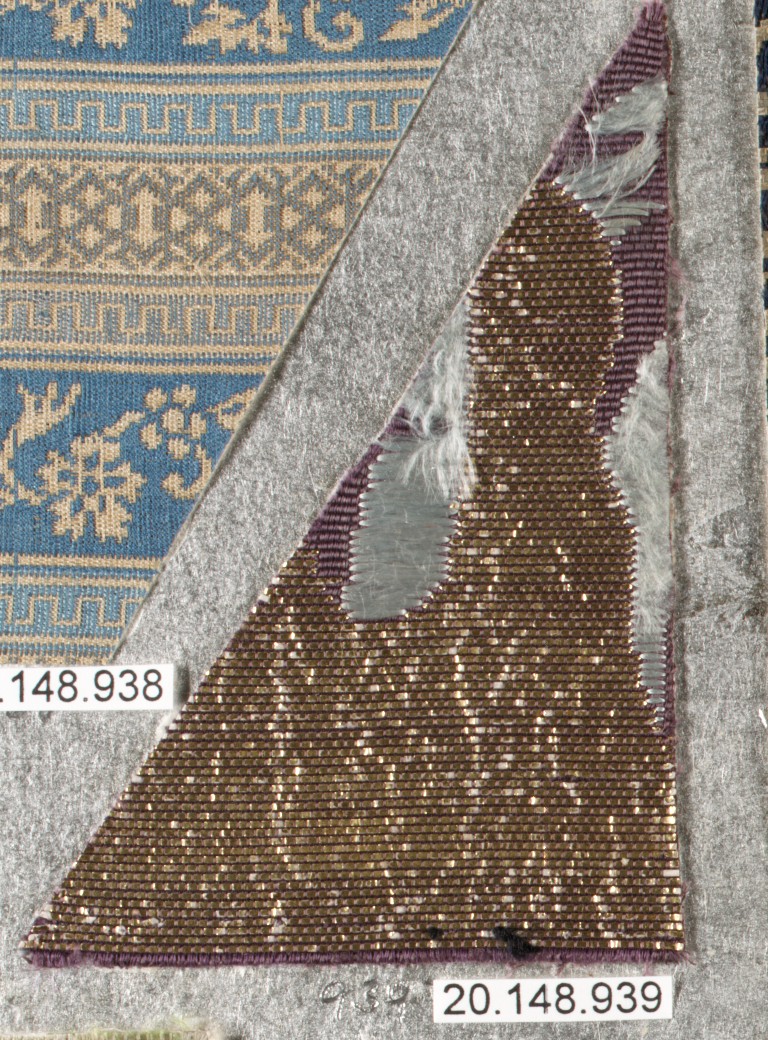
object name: piece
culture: japanese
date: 1601-1800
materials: silk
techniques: compound weave